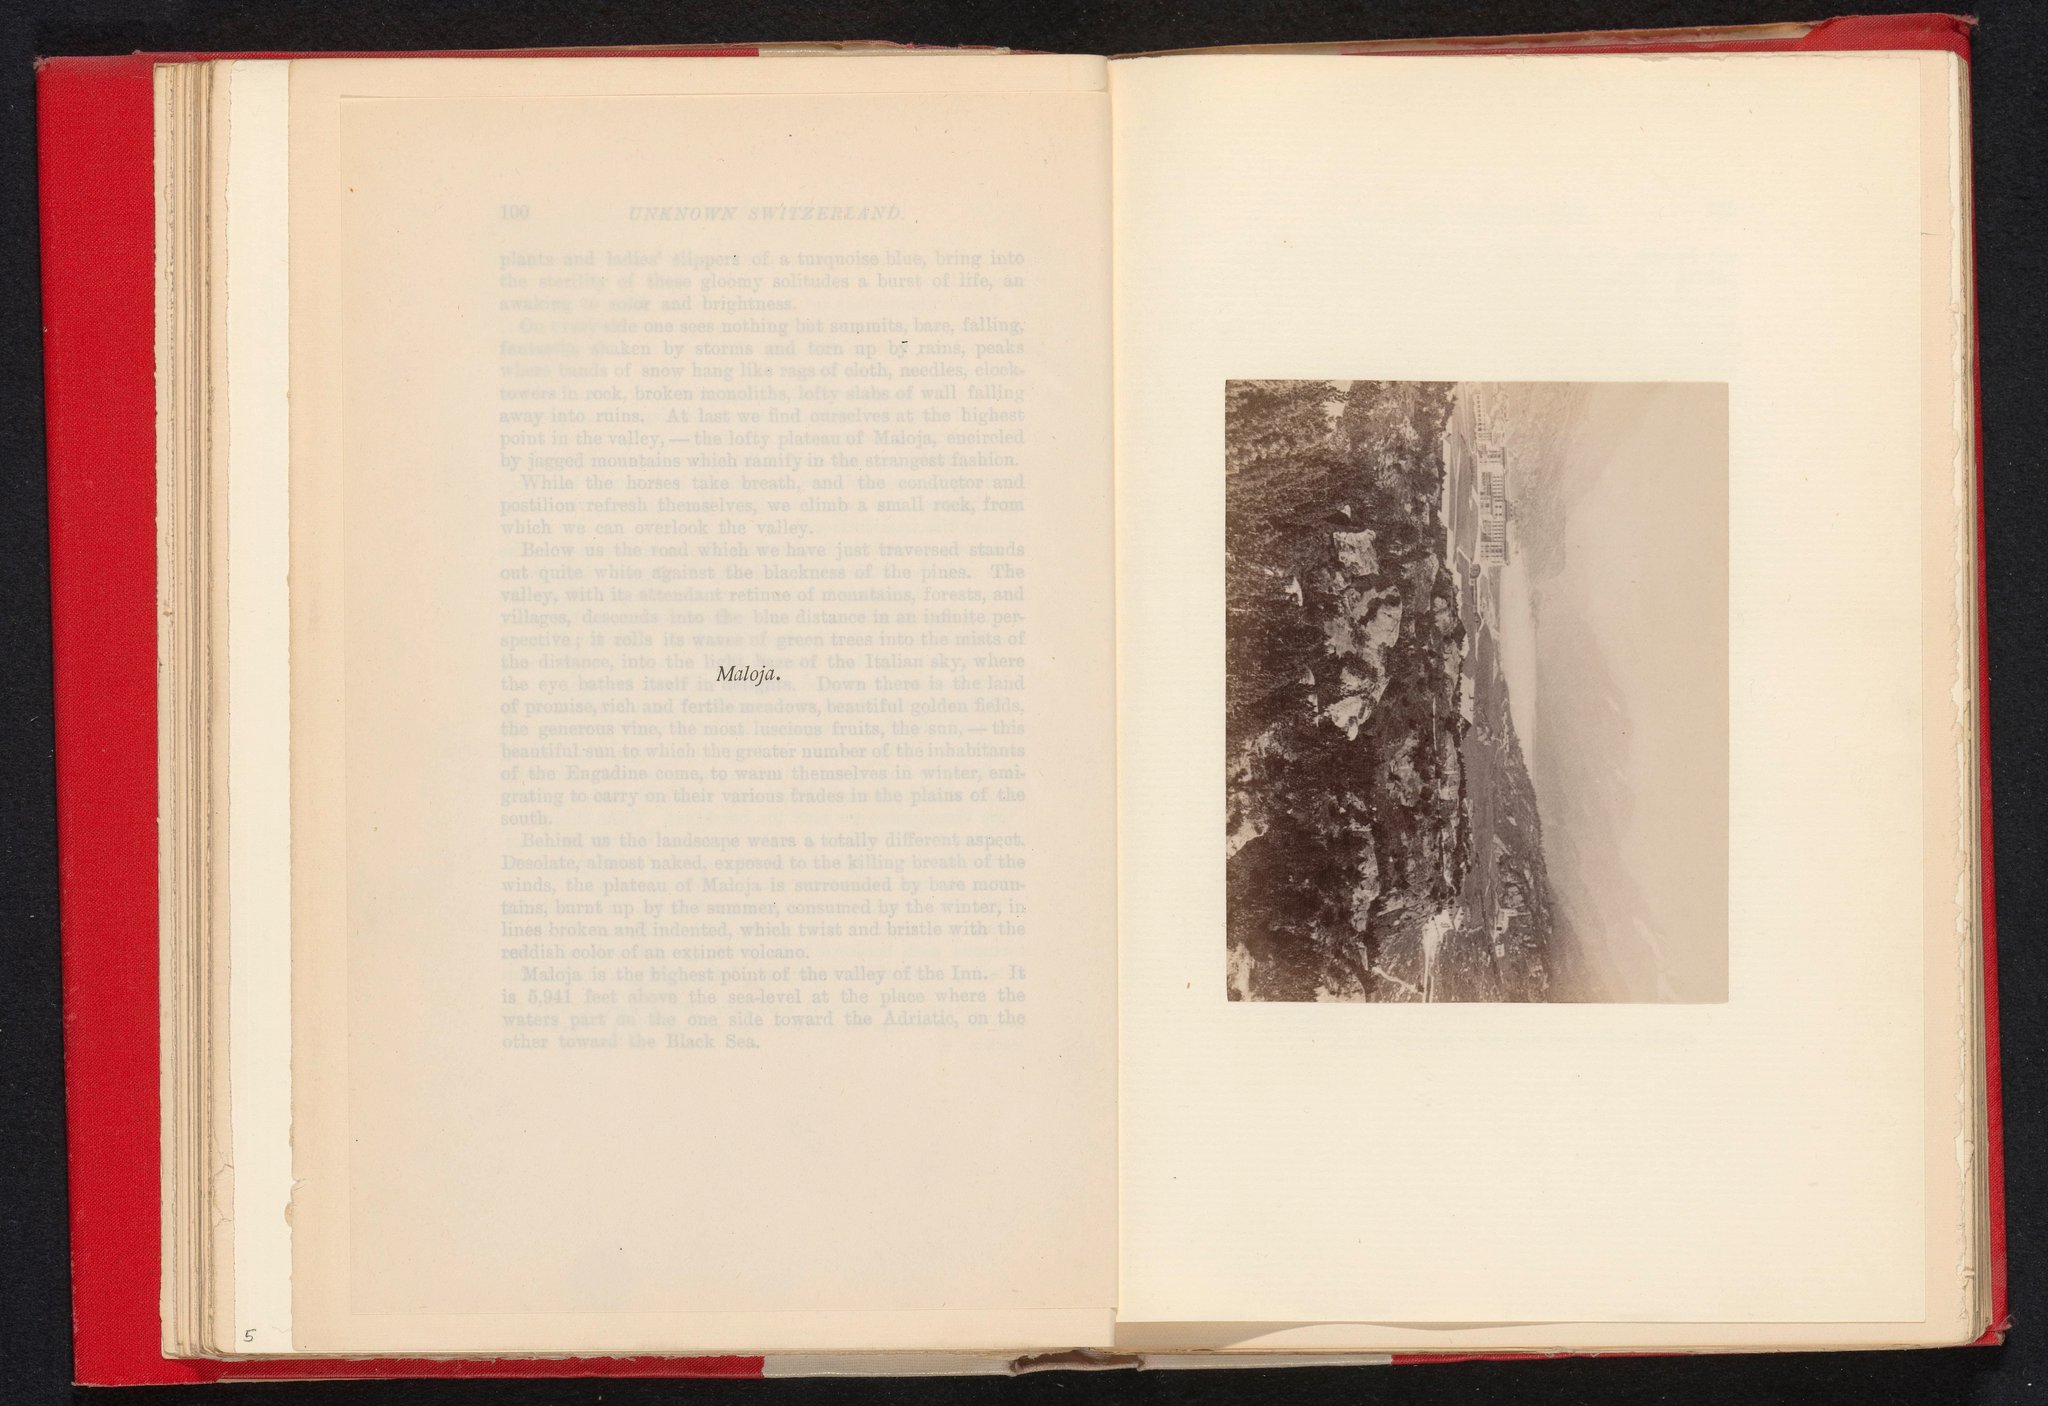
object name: page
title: Maloja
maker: Anonymous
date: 1879-1889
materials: photographic support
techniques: albumen print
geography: graubunden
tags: lake, hotel, hostelry, inn, mountains